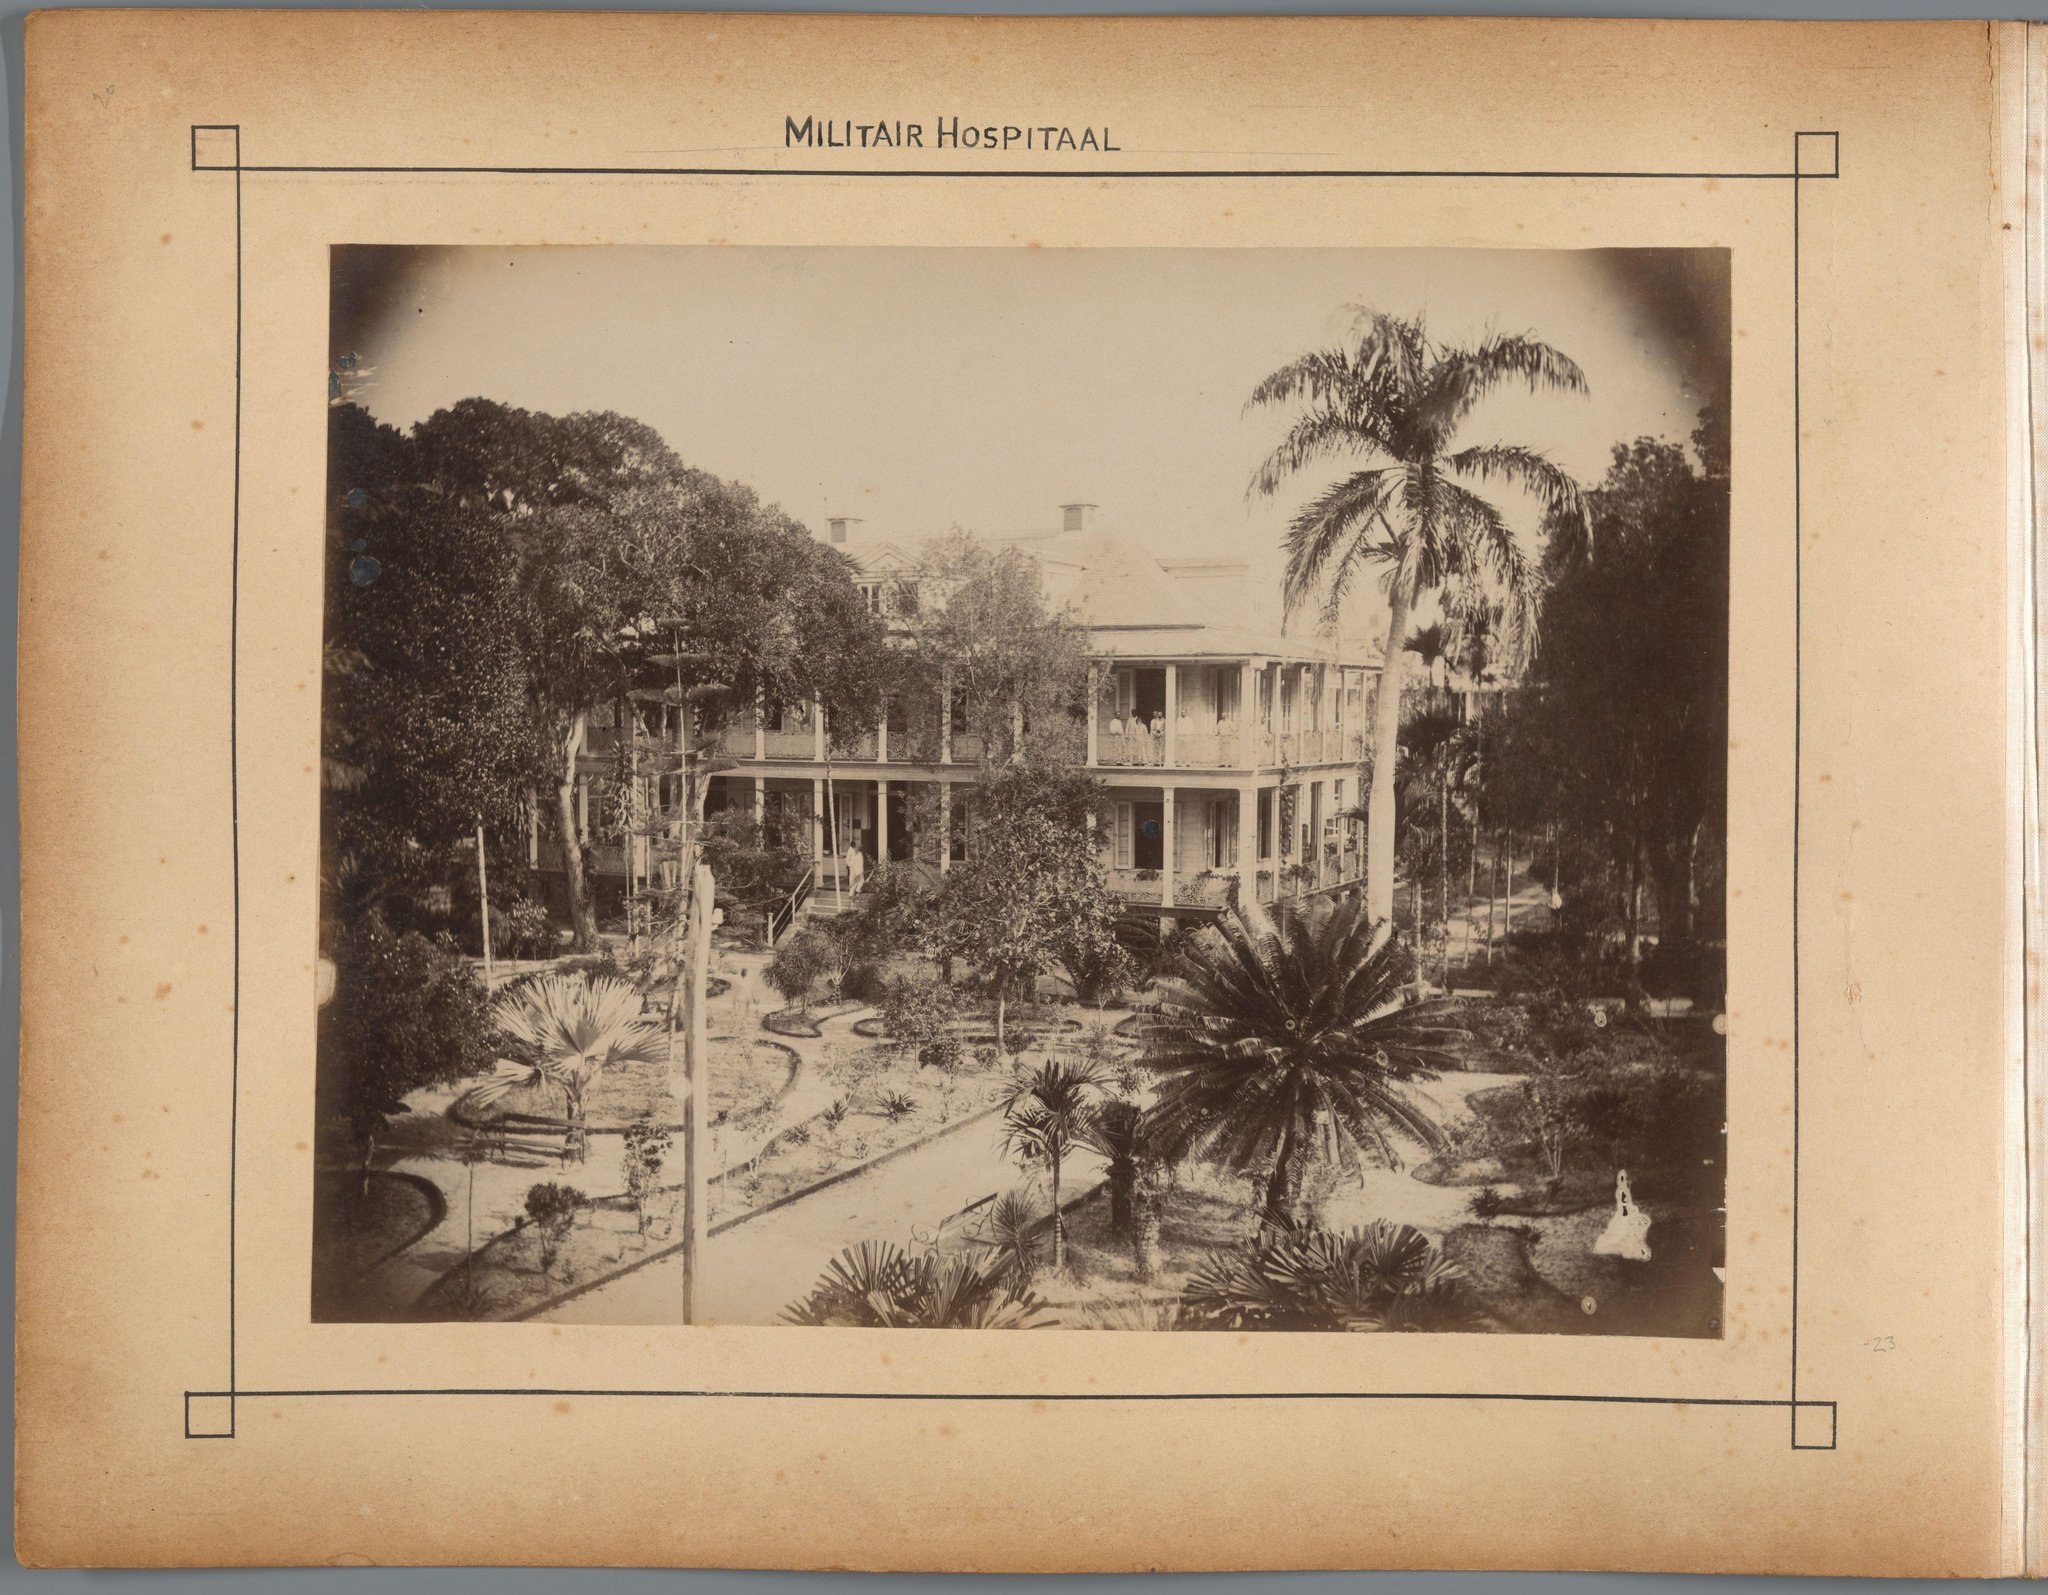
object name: photograph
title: Militair hospitaal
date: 1898-1902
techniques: albumen print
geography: suriname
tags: hospital, suriname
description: Het Militair Hospitaal (nu 's Lands hospitaal), Paramaribo.